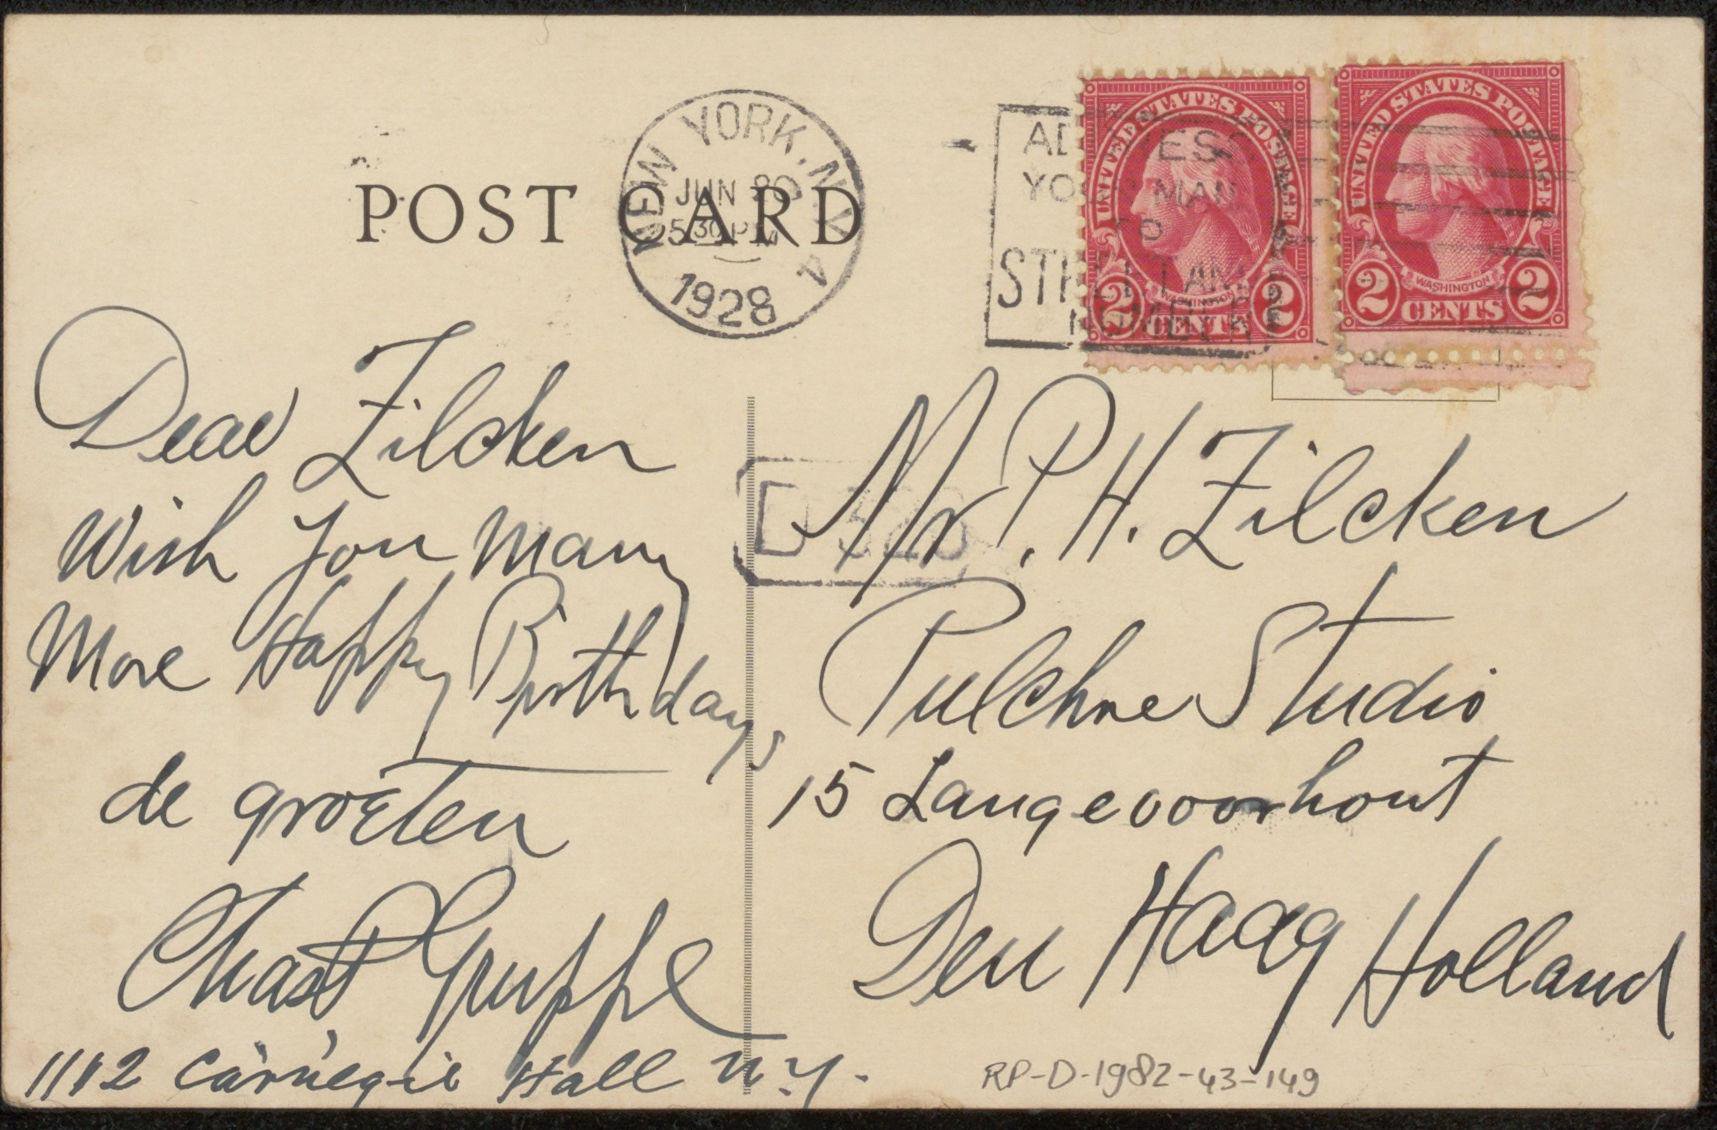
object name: ansichtkaart, prentbriefkaart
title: Prentbriefkaart aan Philip Zilcken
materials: cardboard, ink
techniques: pen, writing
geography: new york city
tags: painter, draughtsman, philip zilcken